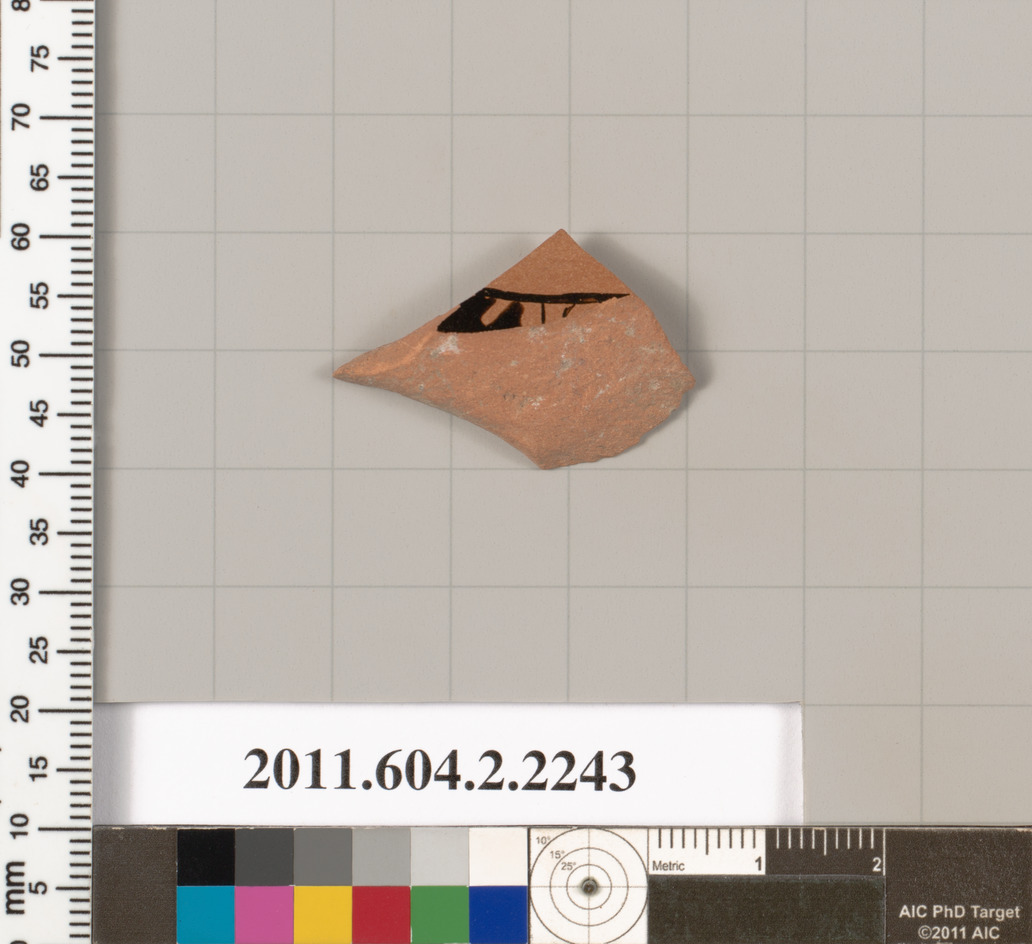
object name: pot fragment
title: Terracotta fragment of a pot; unglazed on the inside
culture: greek, attic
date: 450-426 BCE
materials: terracotta